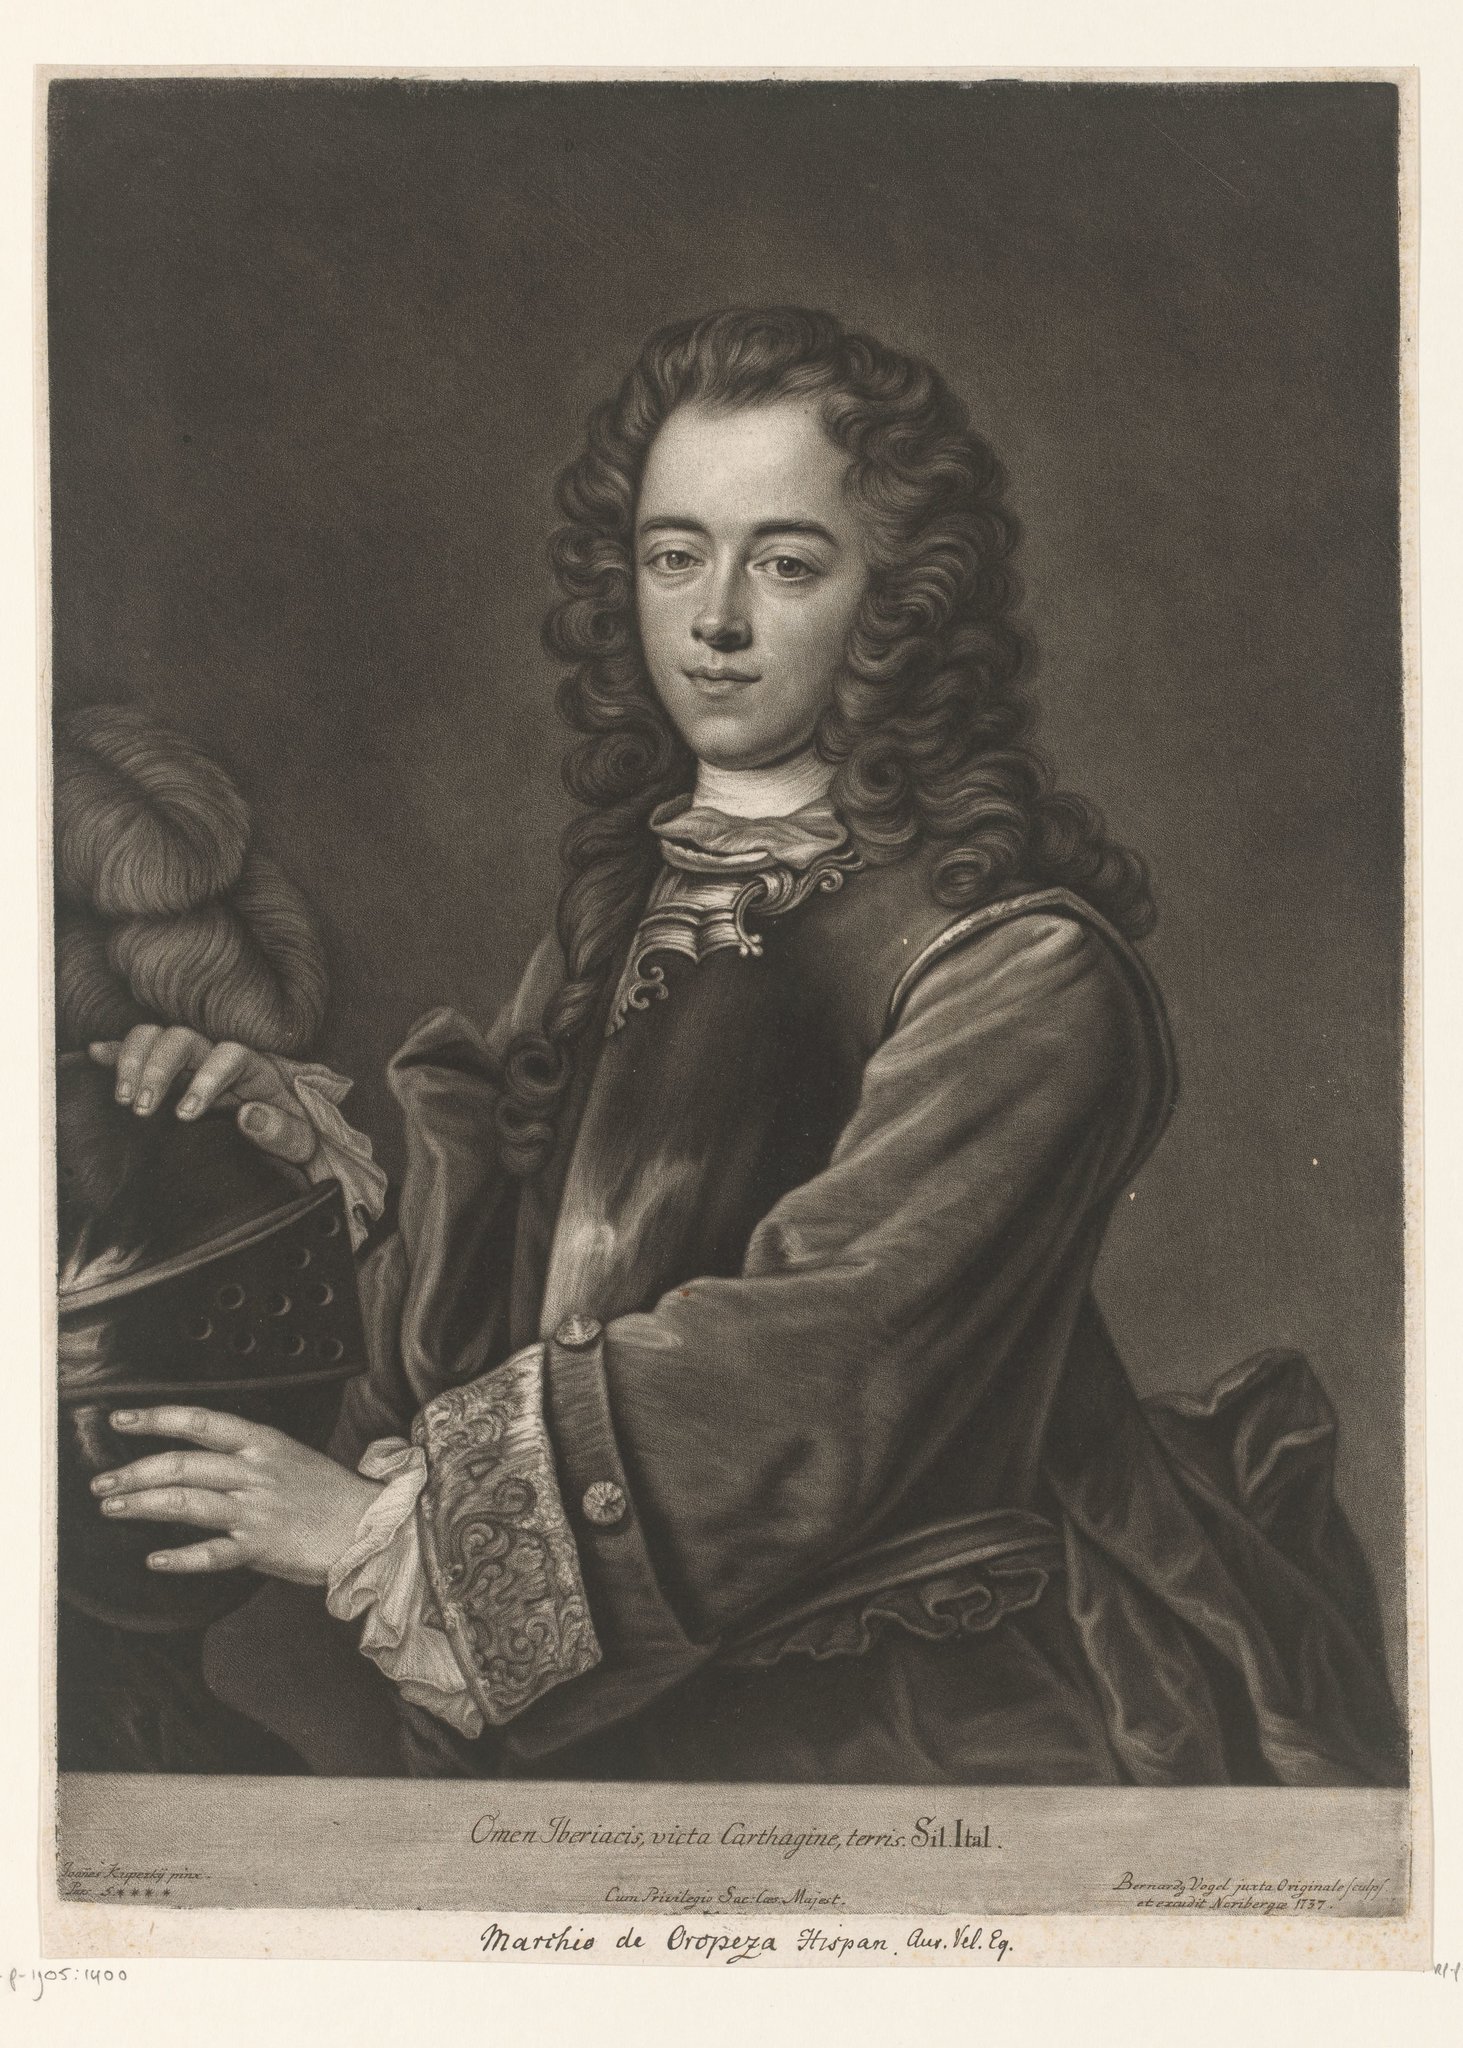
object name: print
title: Portret van Marqués de Oropesa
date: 1737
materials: paper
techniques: mezzotint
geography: nuremberg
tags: historical persons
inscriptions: name, collector's mark: Lugt 2228